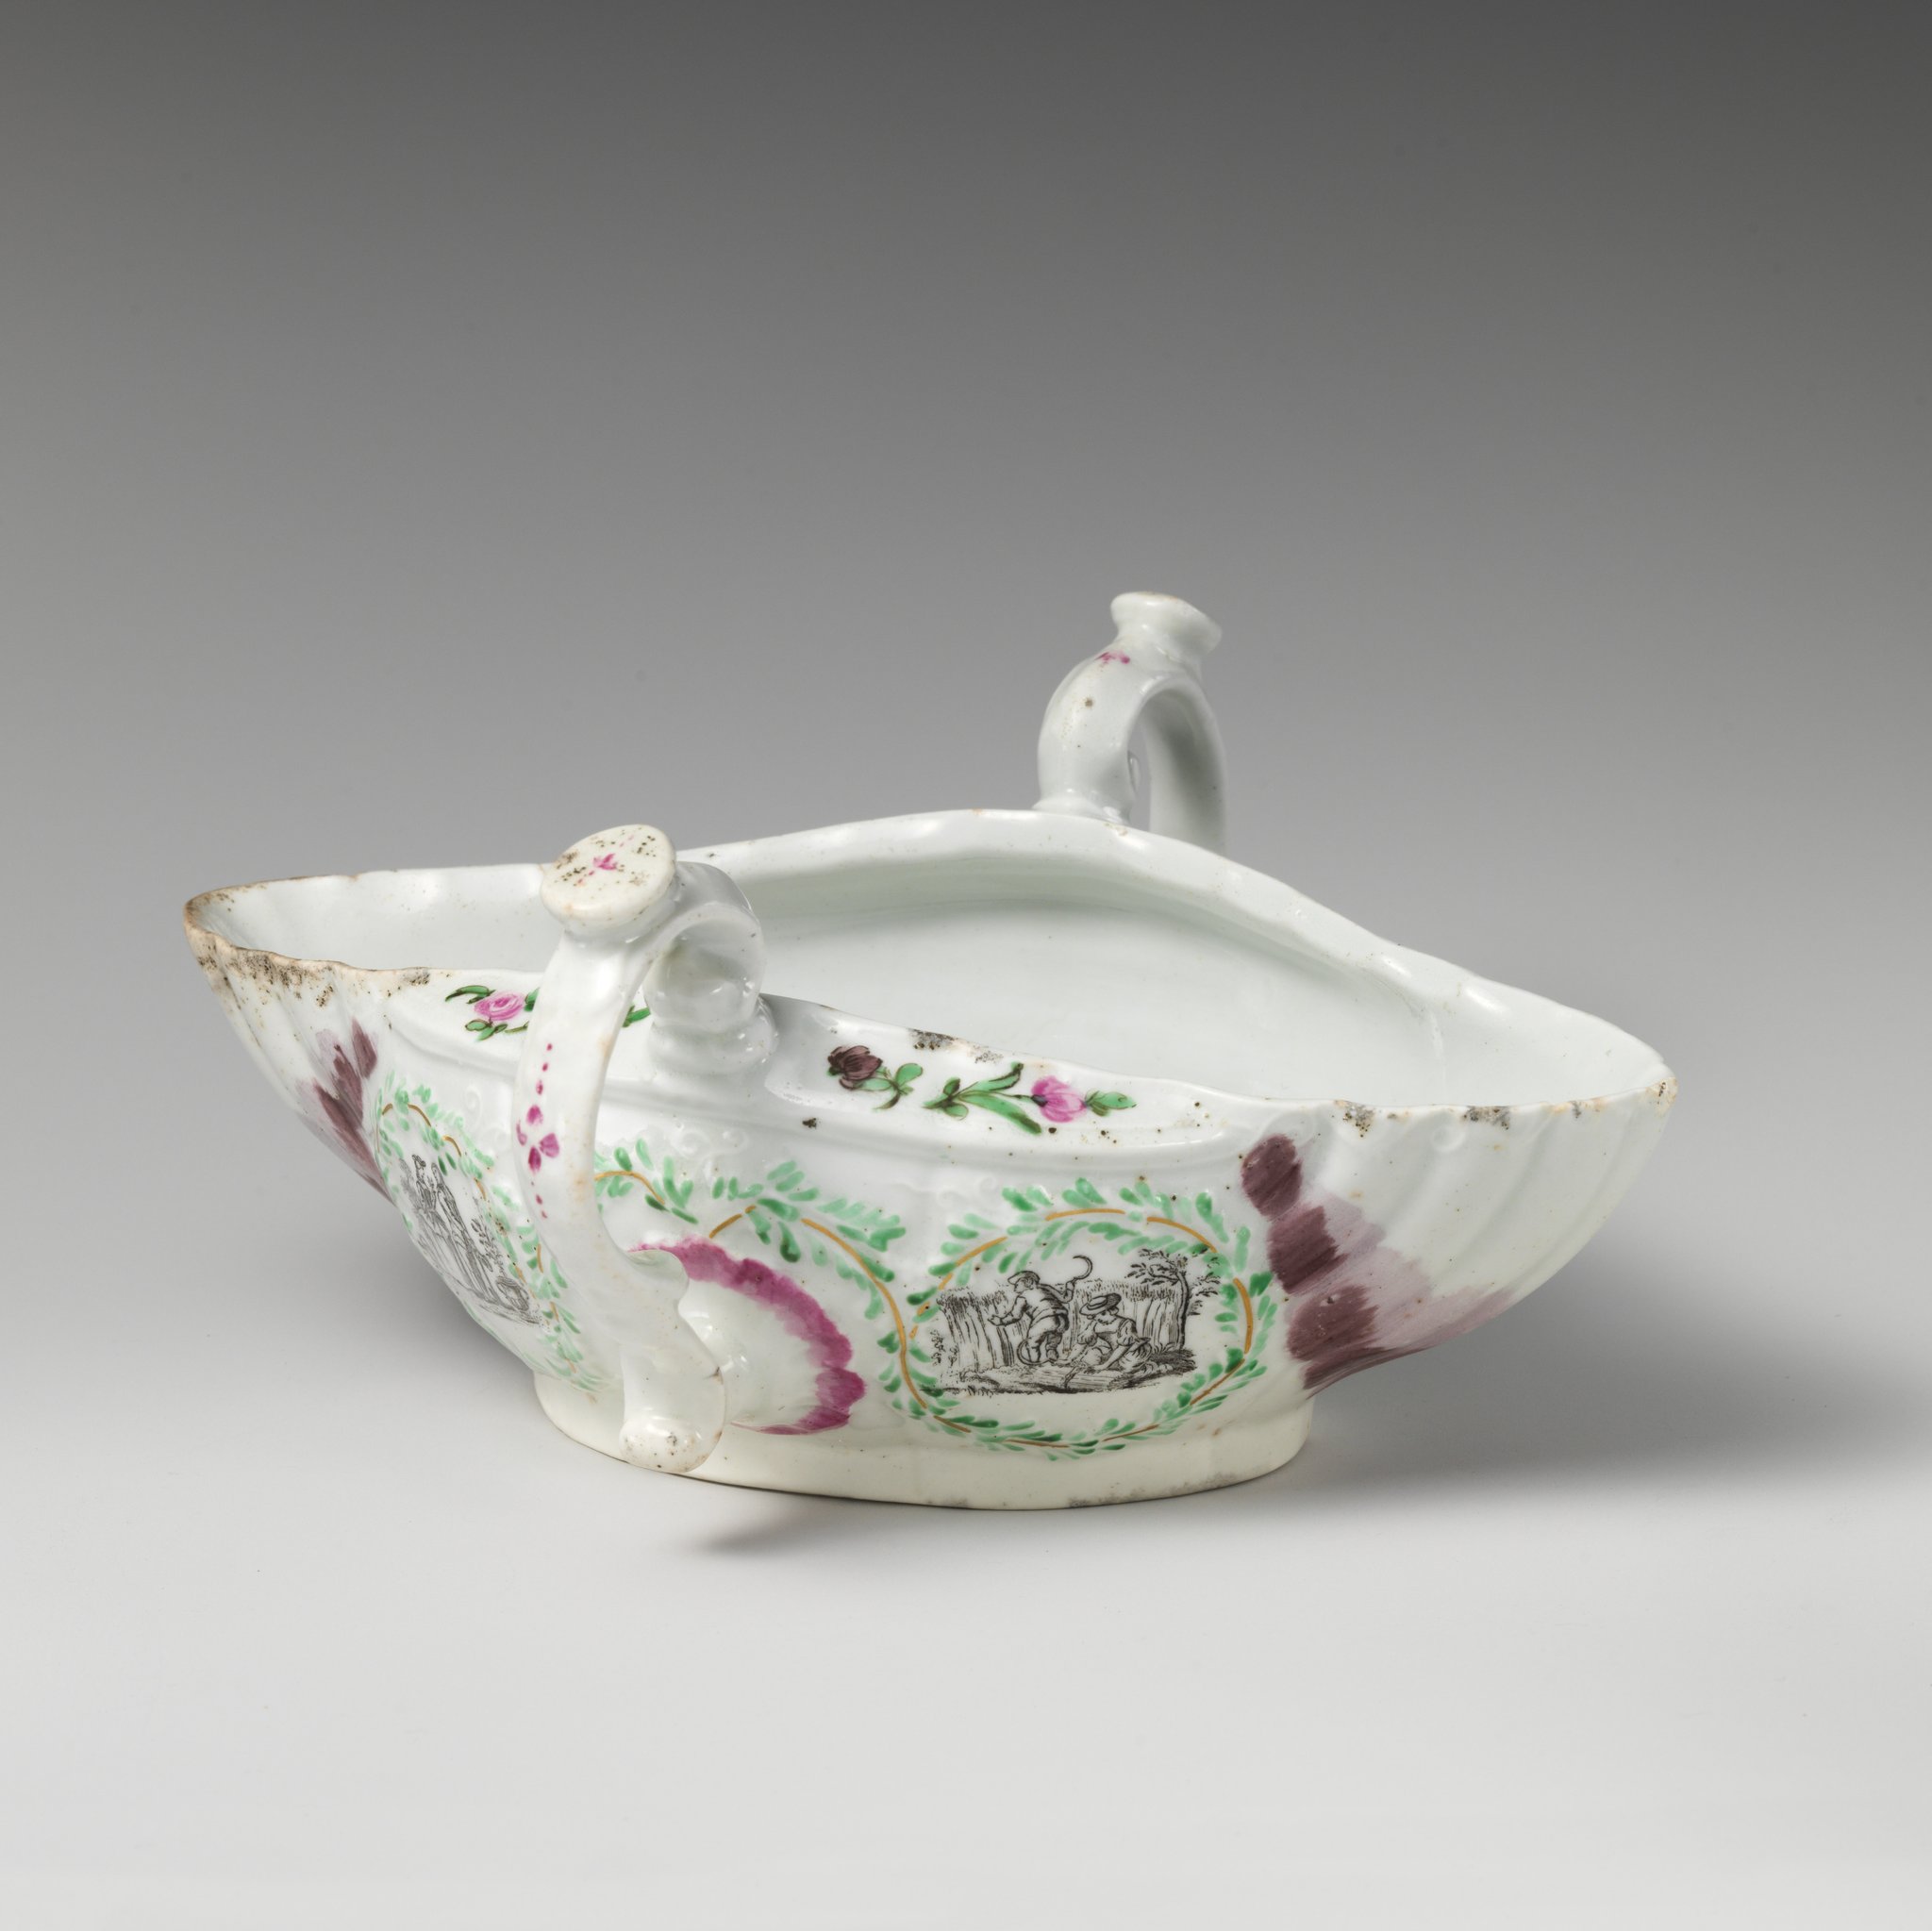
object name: sauceboat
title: Double-handle sauceboat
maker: worcester factory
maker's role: factory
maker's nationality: british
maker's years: 1751-2008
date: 1754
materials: soft paste porcelain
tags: swans,trees,farmers